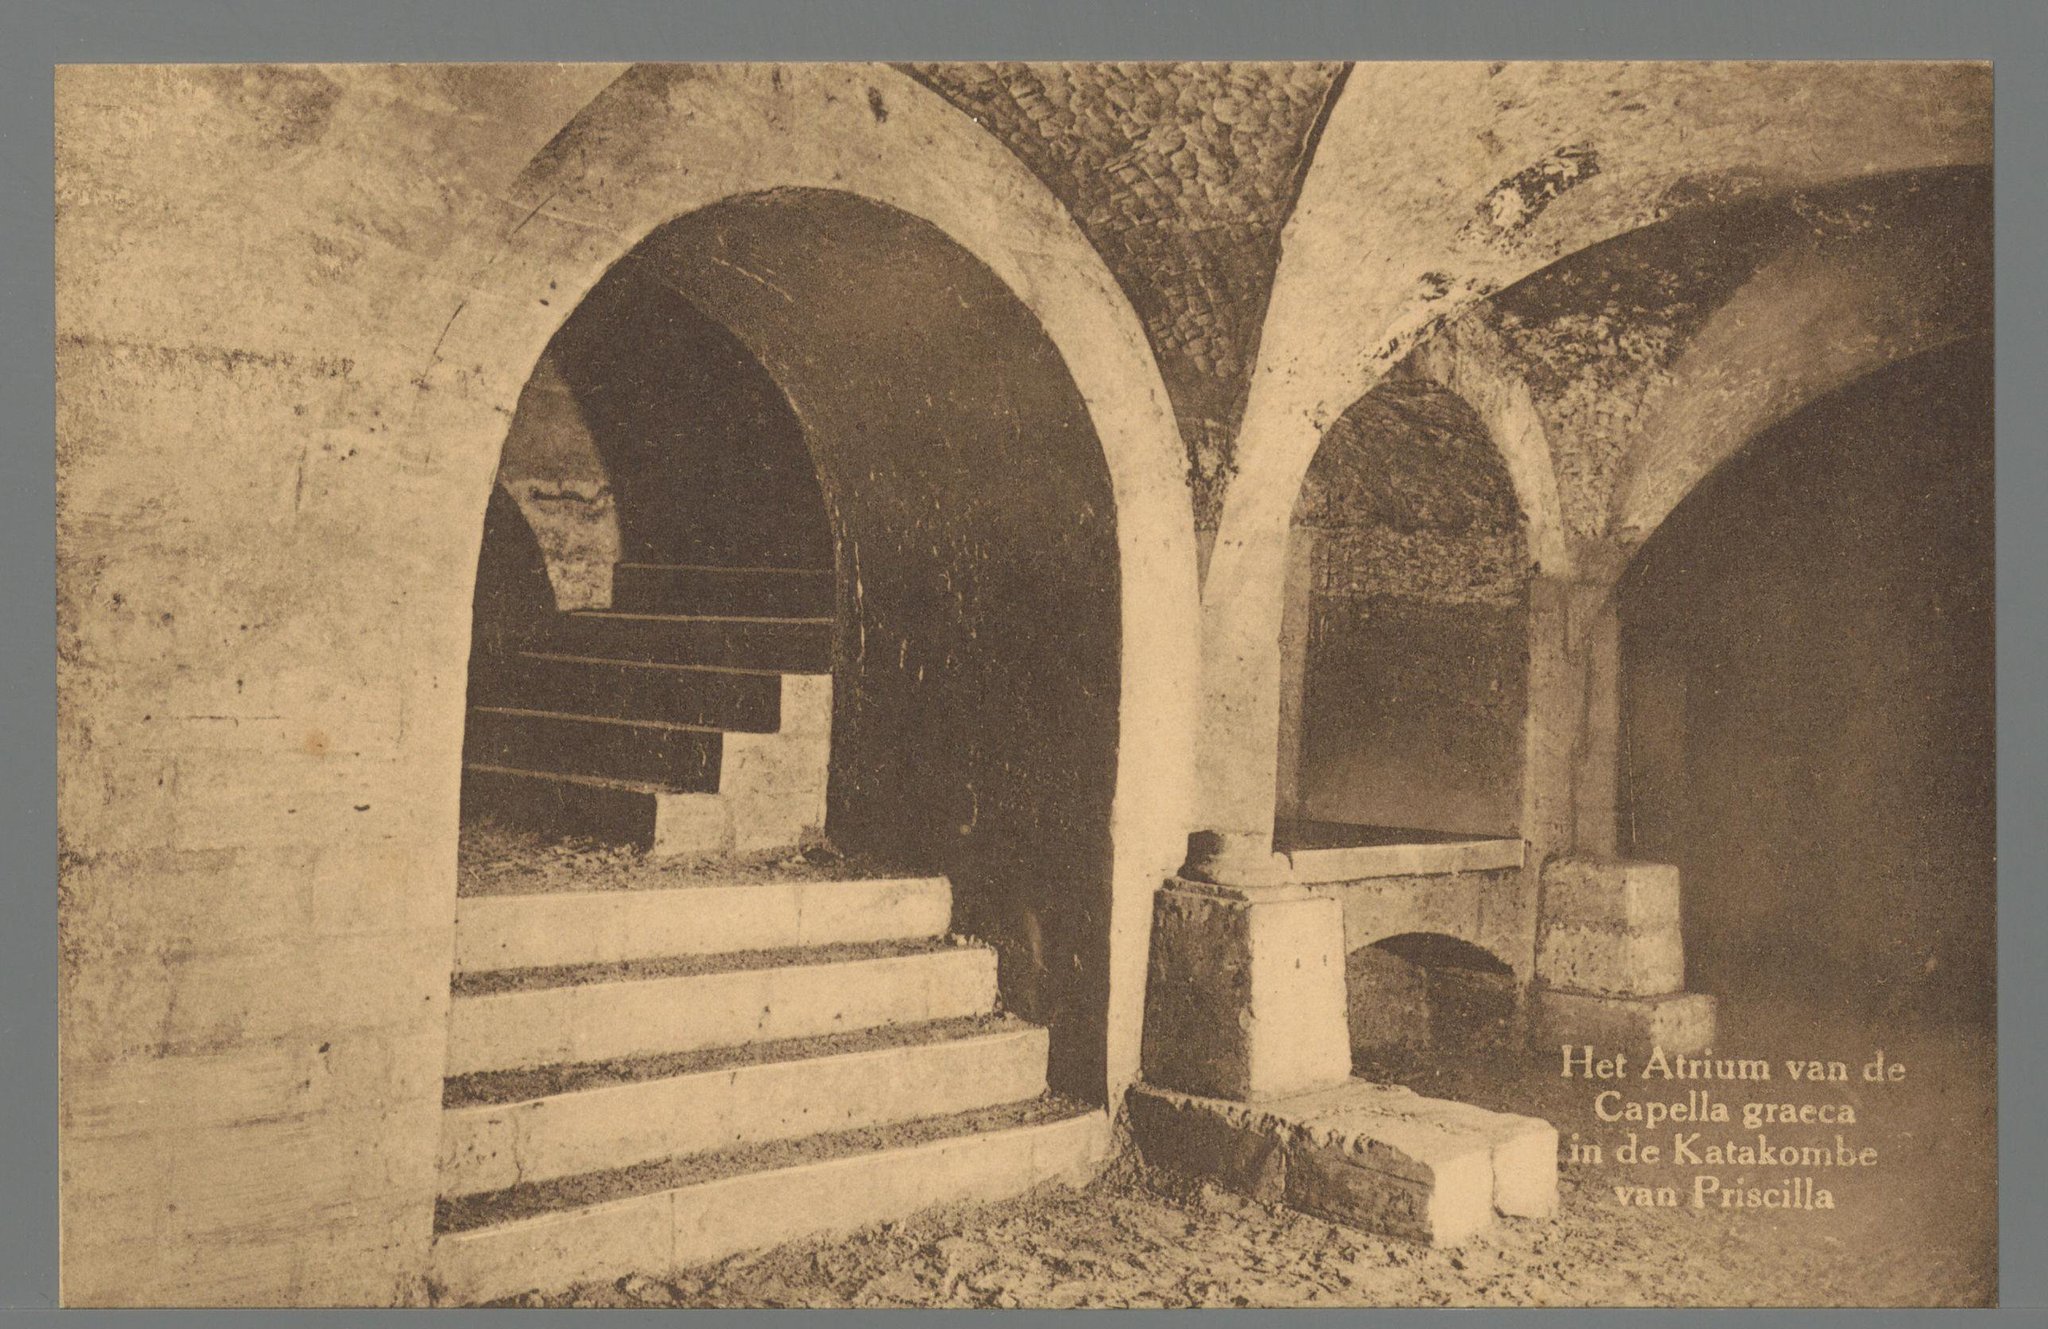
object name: ansichtkaart, prentbriefkaart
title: Romeinsche Katakomben. Valkenburg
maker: Anonymous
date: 1905-1930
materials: cardboard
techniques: photograph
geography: valkenburg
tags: interior ~ representation of a building, catacombs